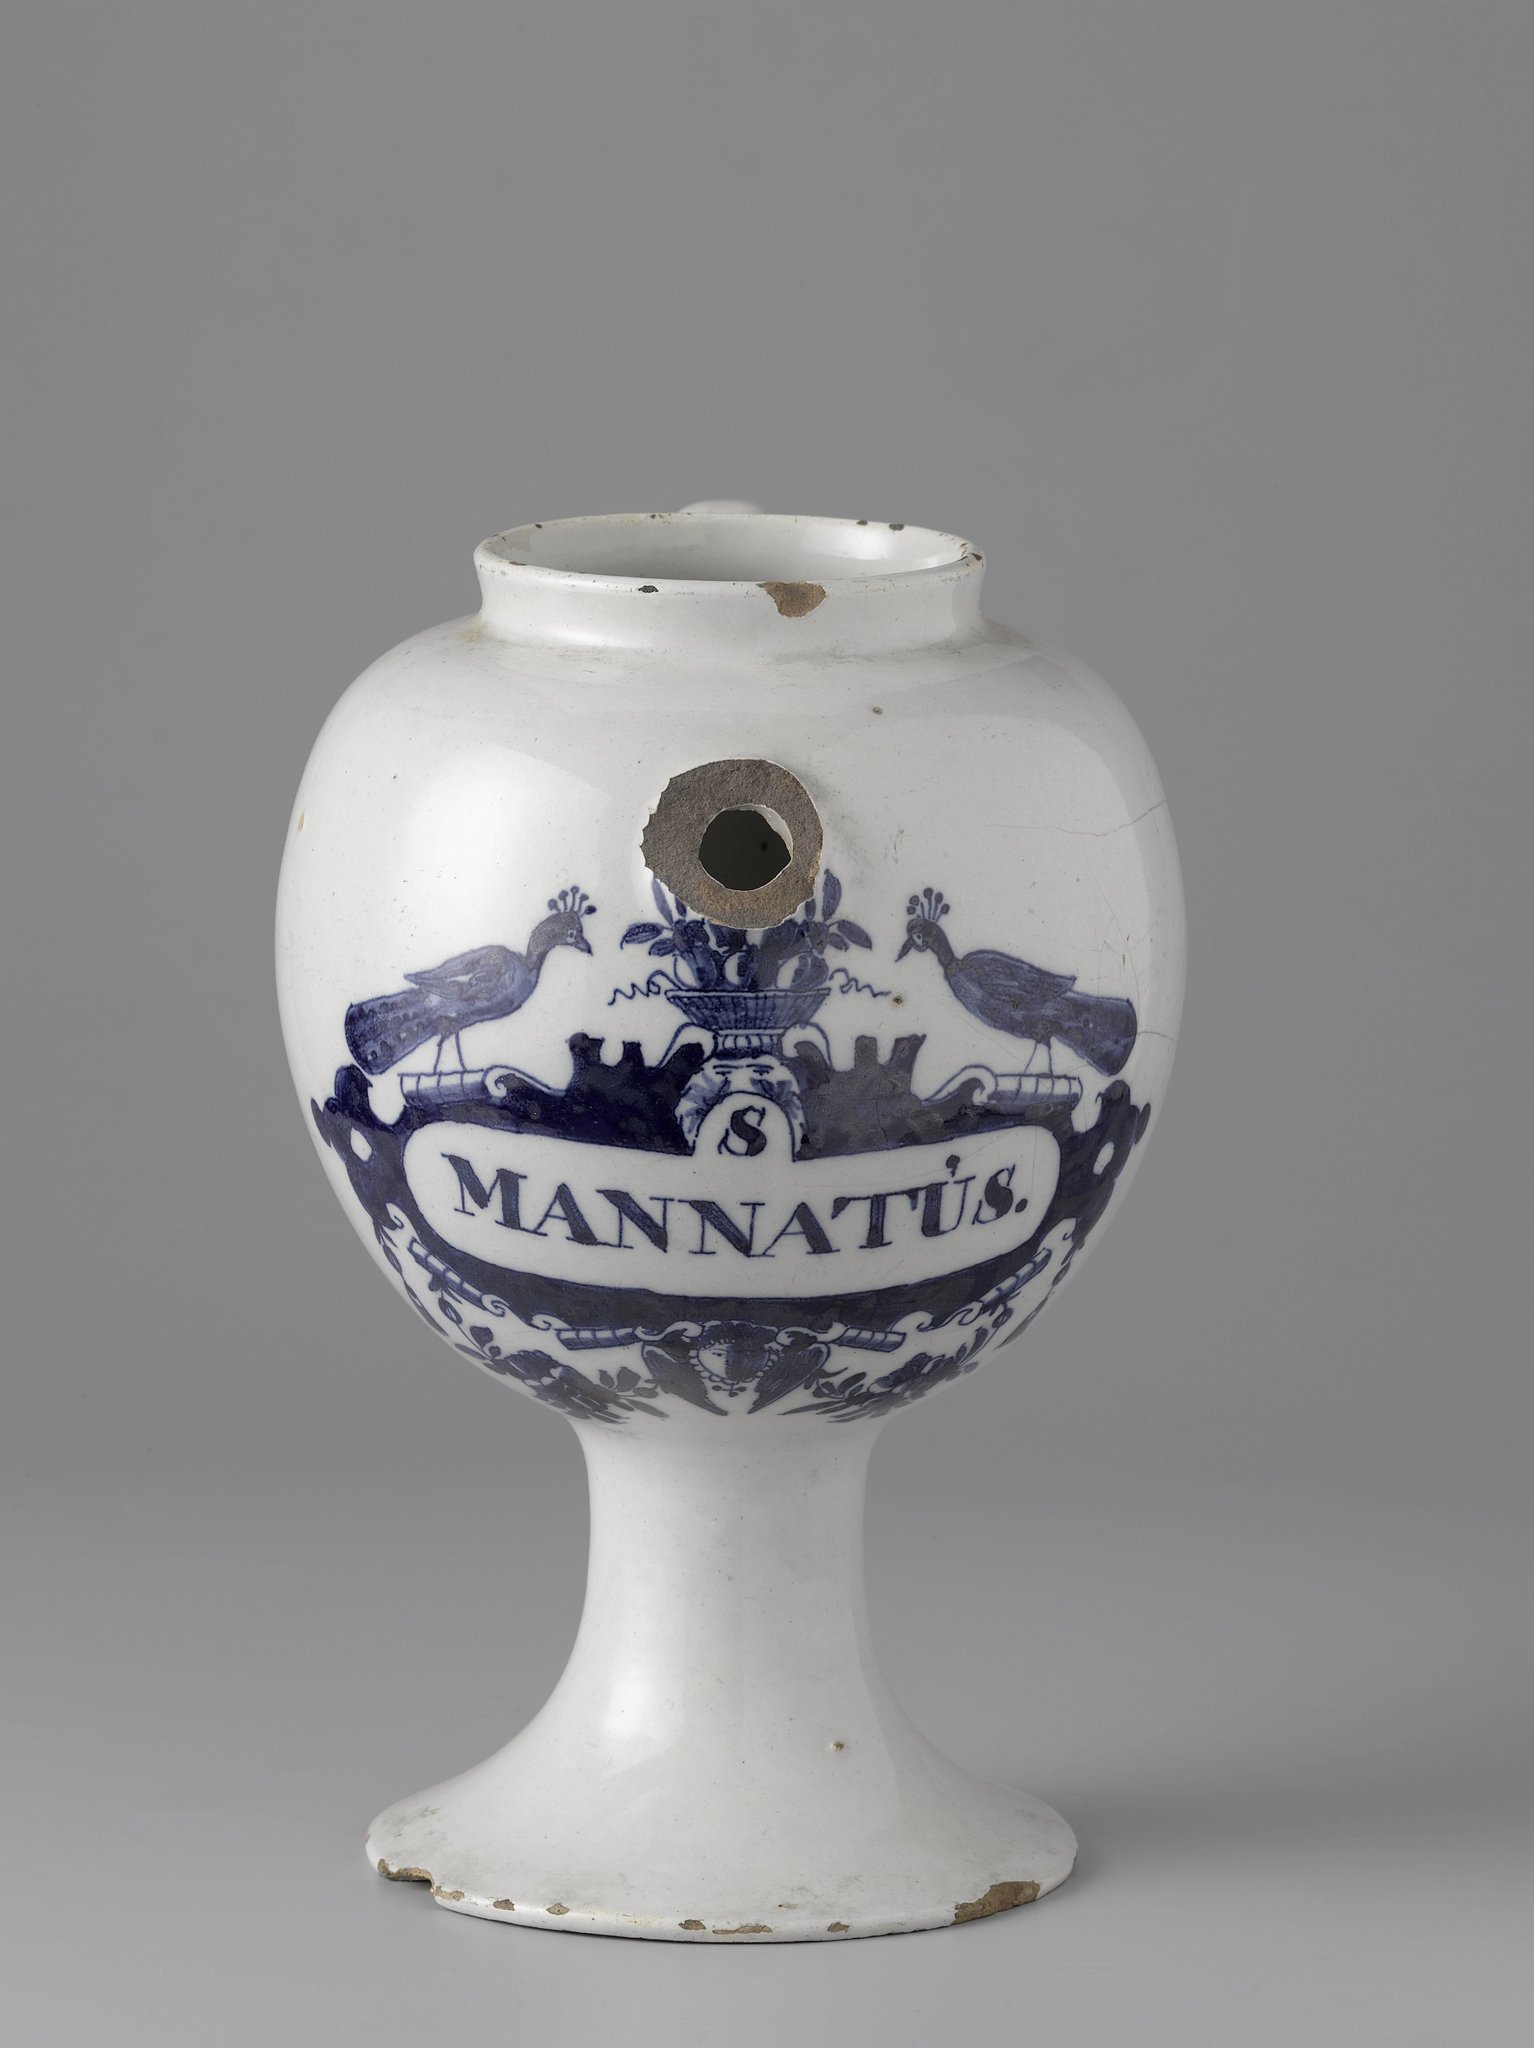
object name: apothecary jar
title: Apothekerspot 'S MANNATUS'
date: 1740-1775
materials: faience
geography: delft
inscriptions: mark: ‘lpk’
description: Apothekerspot van faience. Blauw beschilderd met opschrift: MANNATUS.